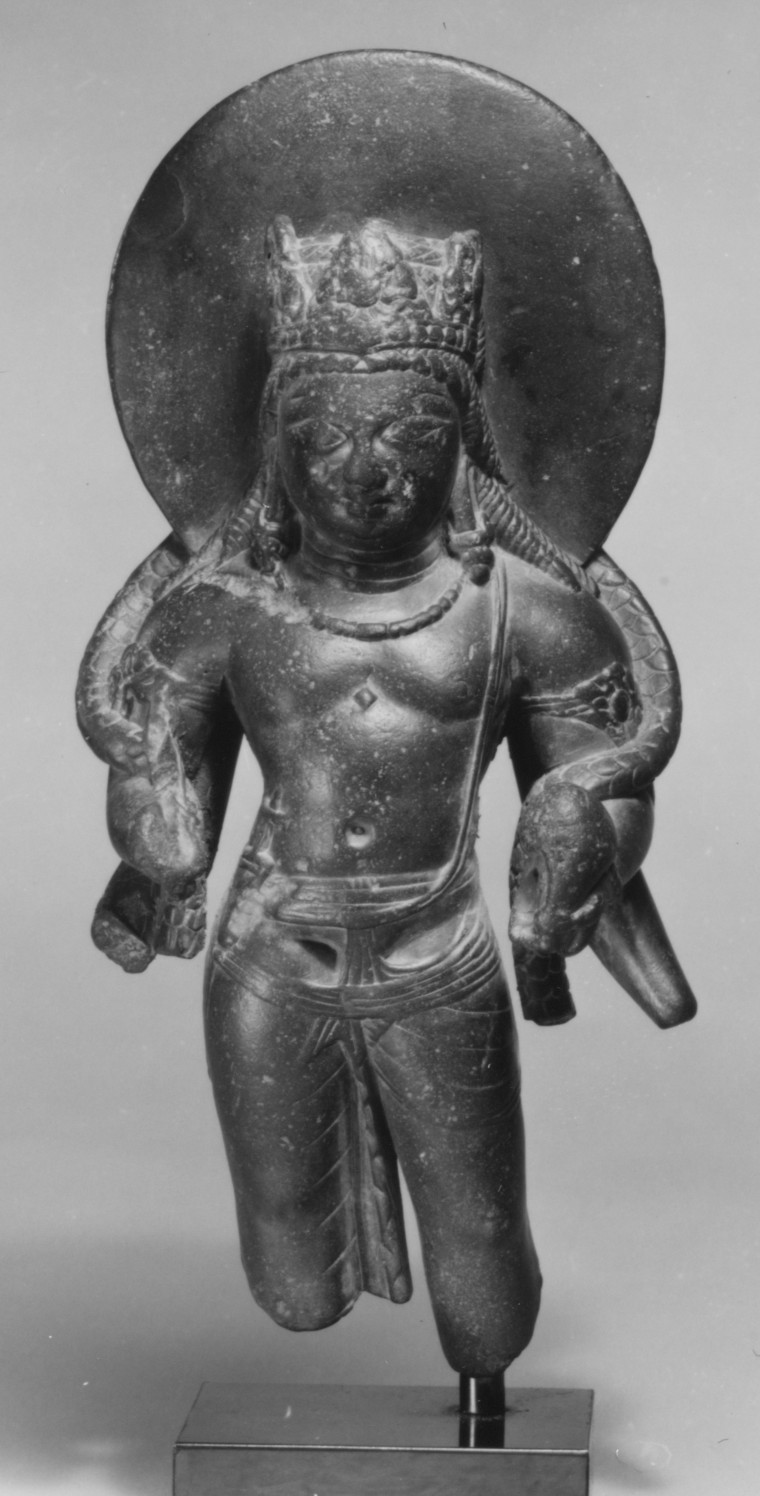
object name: figure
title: Standing Four-Armed Vishnu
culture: kashmiri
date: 701-800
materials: stone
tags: kashmir,vishnu